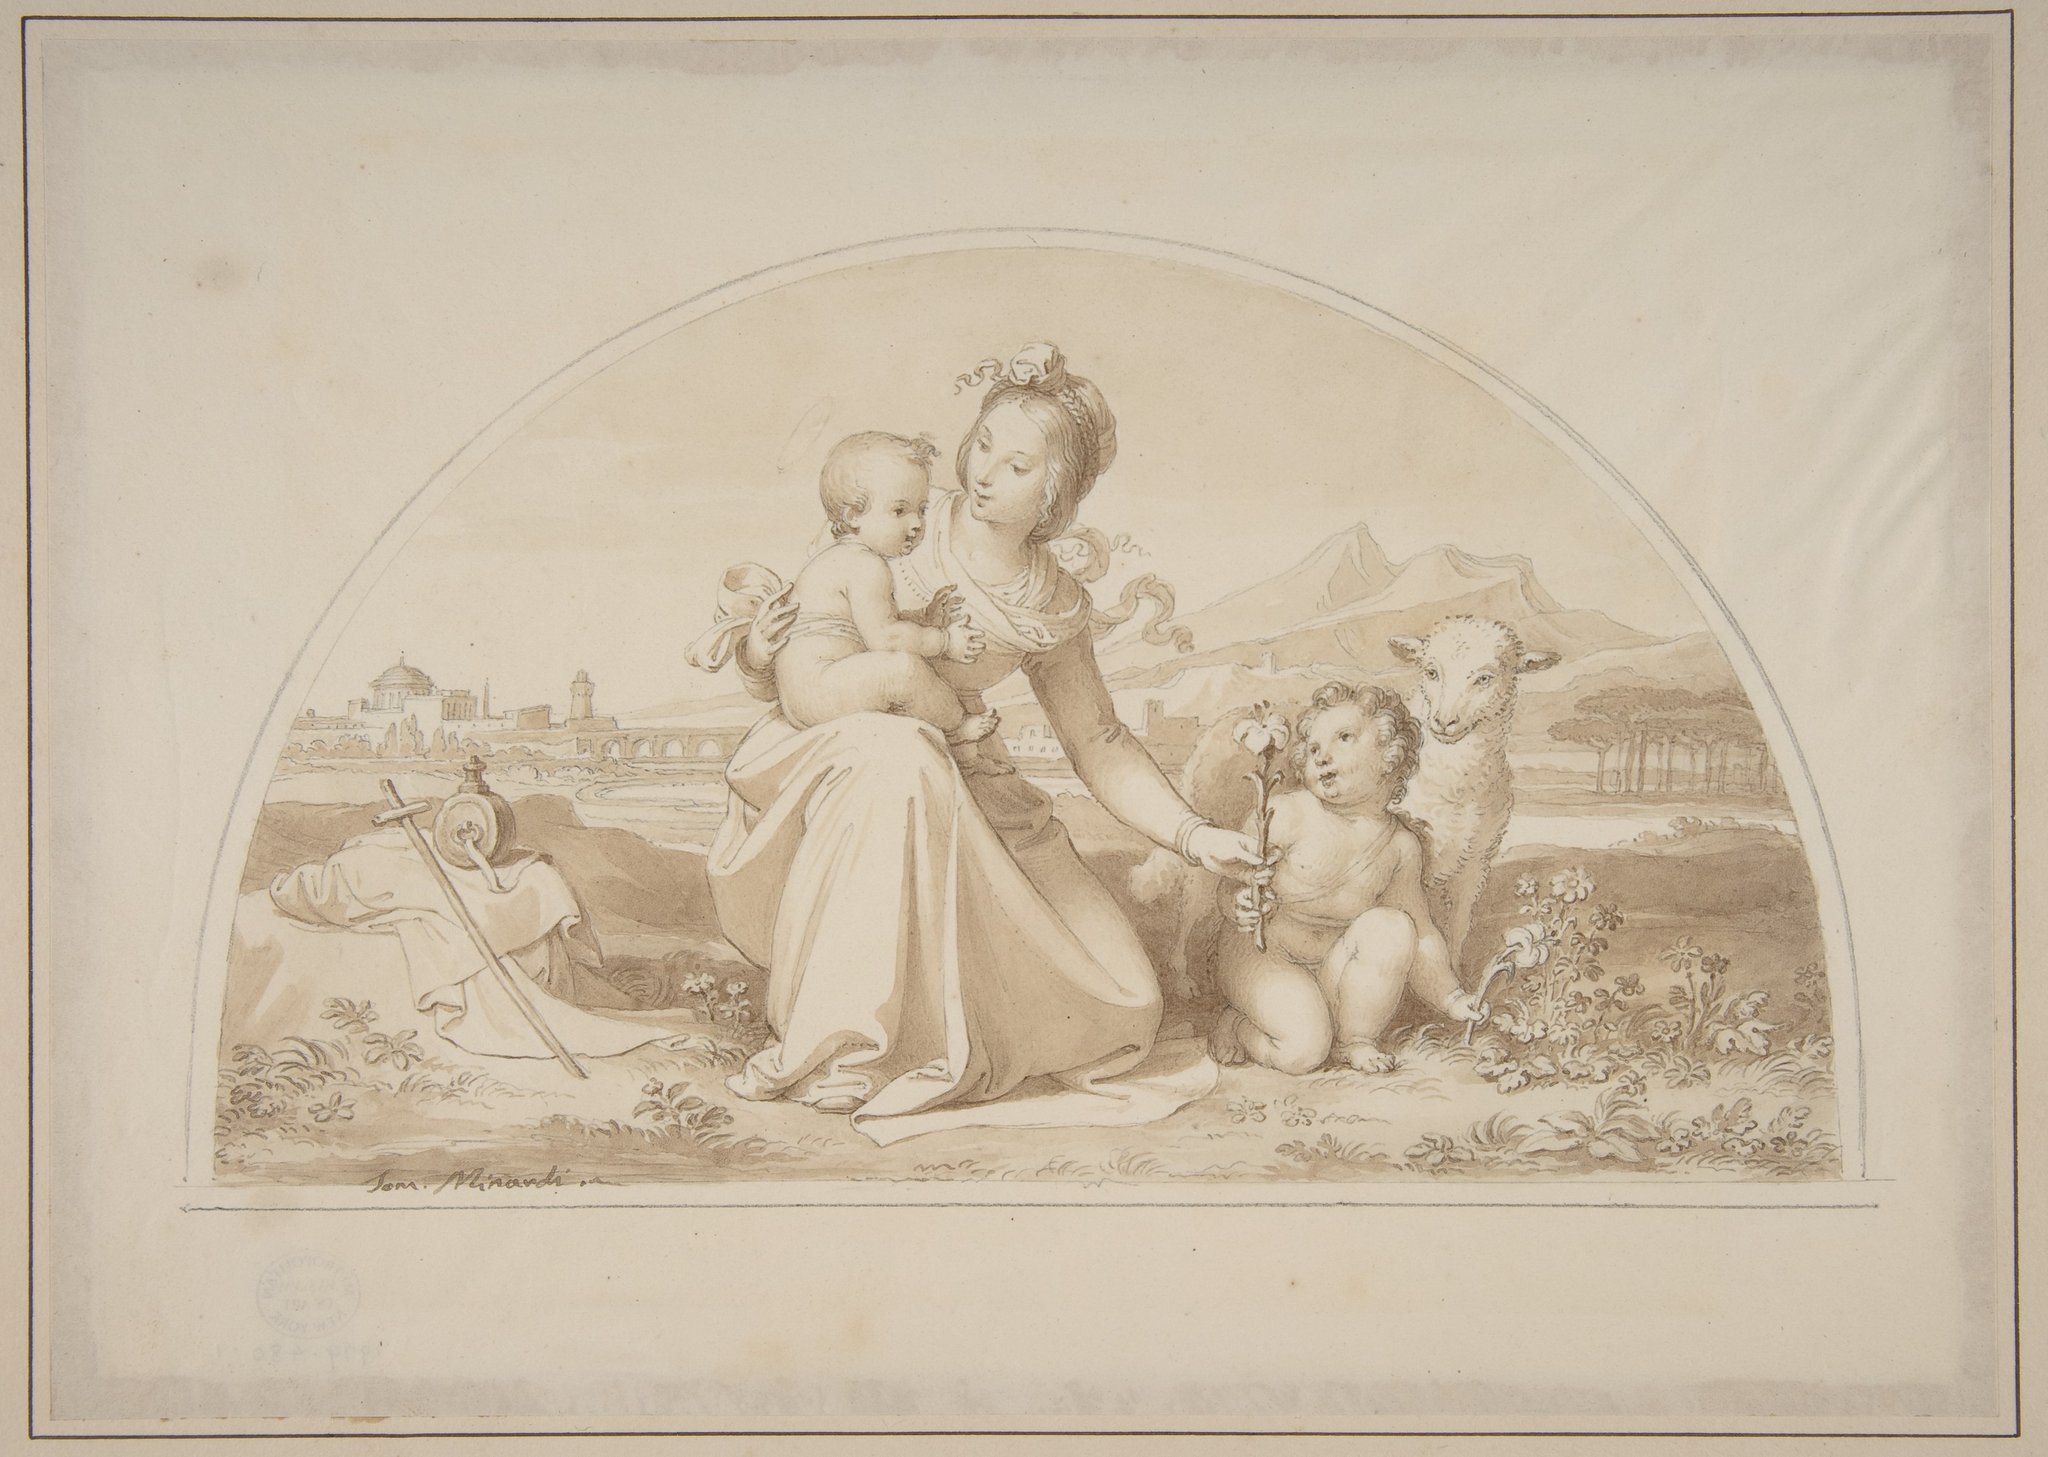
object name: drawing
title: The Virgin and Child with the Infant John the Baptist and a Lamb in a Landscape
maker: tommaso minardi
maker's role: artist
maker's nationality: italian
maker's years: 1787-1871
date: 1787-1871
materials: ink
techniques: brush, pen, wash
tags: sheep,madonna and child,saint john the baptist,cross